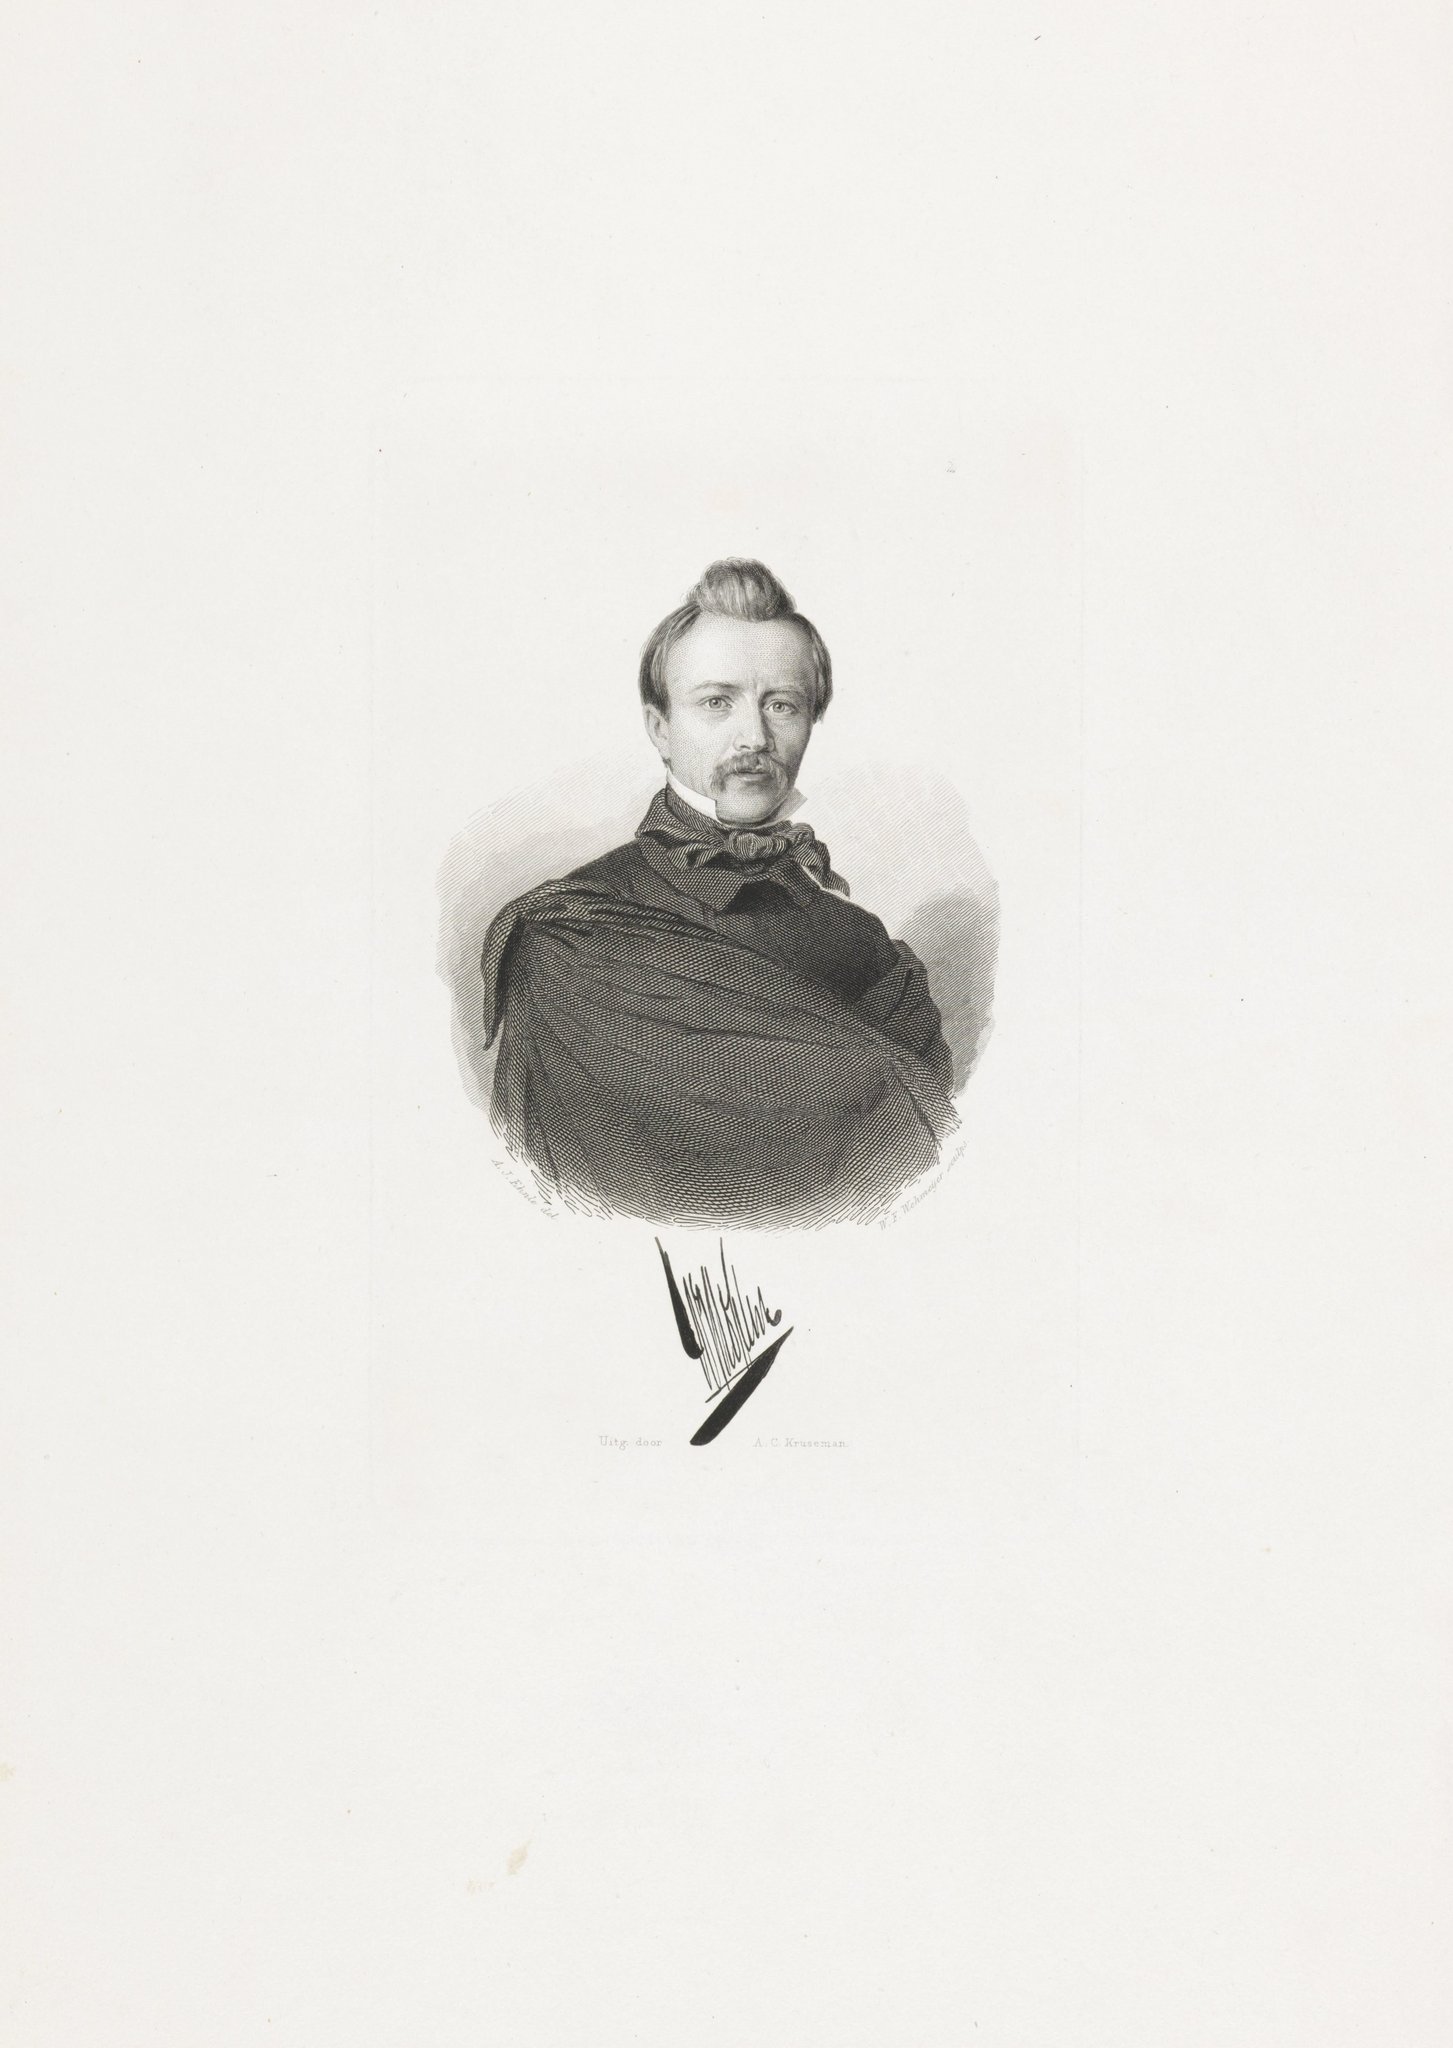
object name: print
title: Portret van Willem Jacobsz. Hofdijk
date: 1842-1873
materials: paper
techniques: engraving, etching, roulette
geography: haarlem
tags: arnhem, adult man, historical persons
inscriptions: collector's mark: Lugt 2228, collector's mark: Lugt 2760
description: Portret van Willem Jacobsz. Hofdijk, dichter, proza- en toneelschrijver. Onder de voorstelling bevindt zich de signatuur van de geportretteerde.